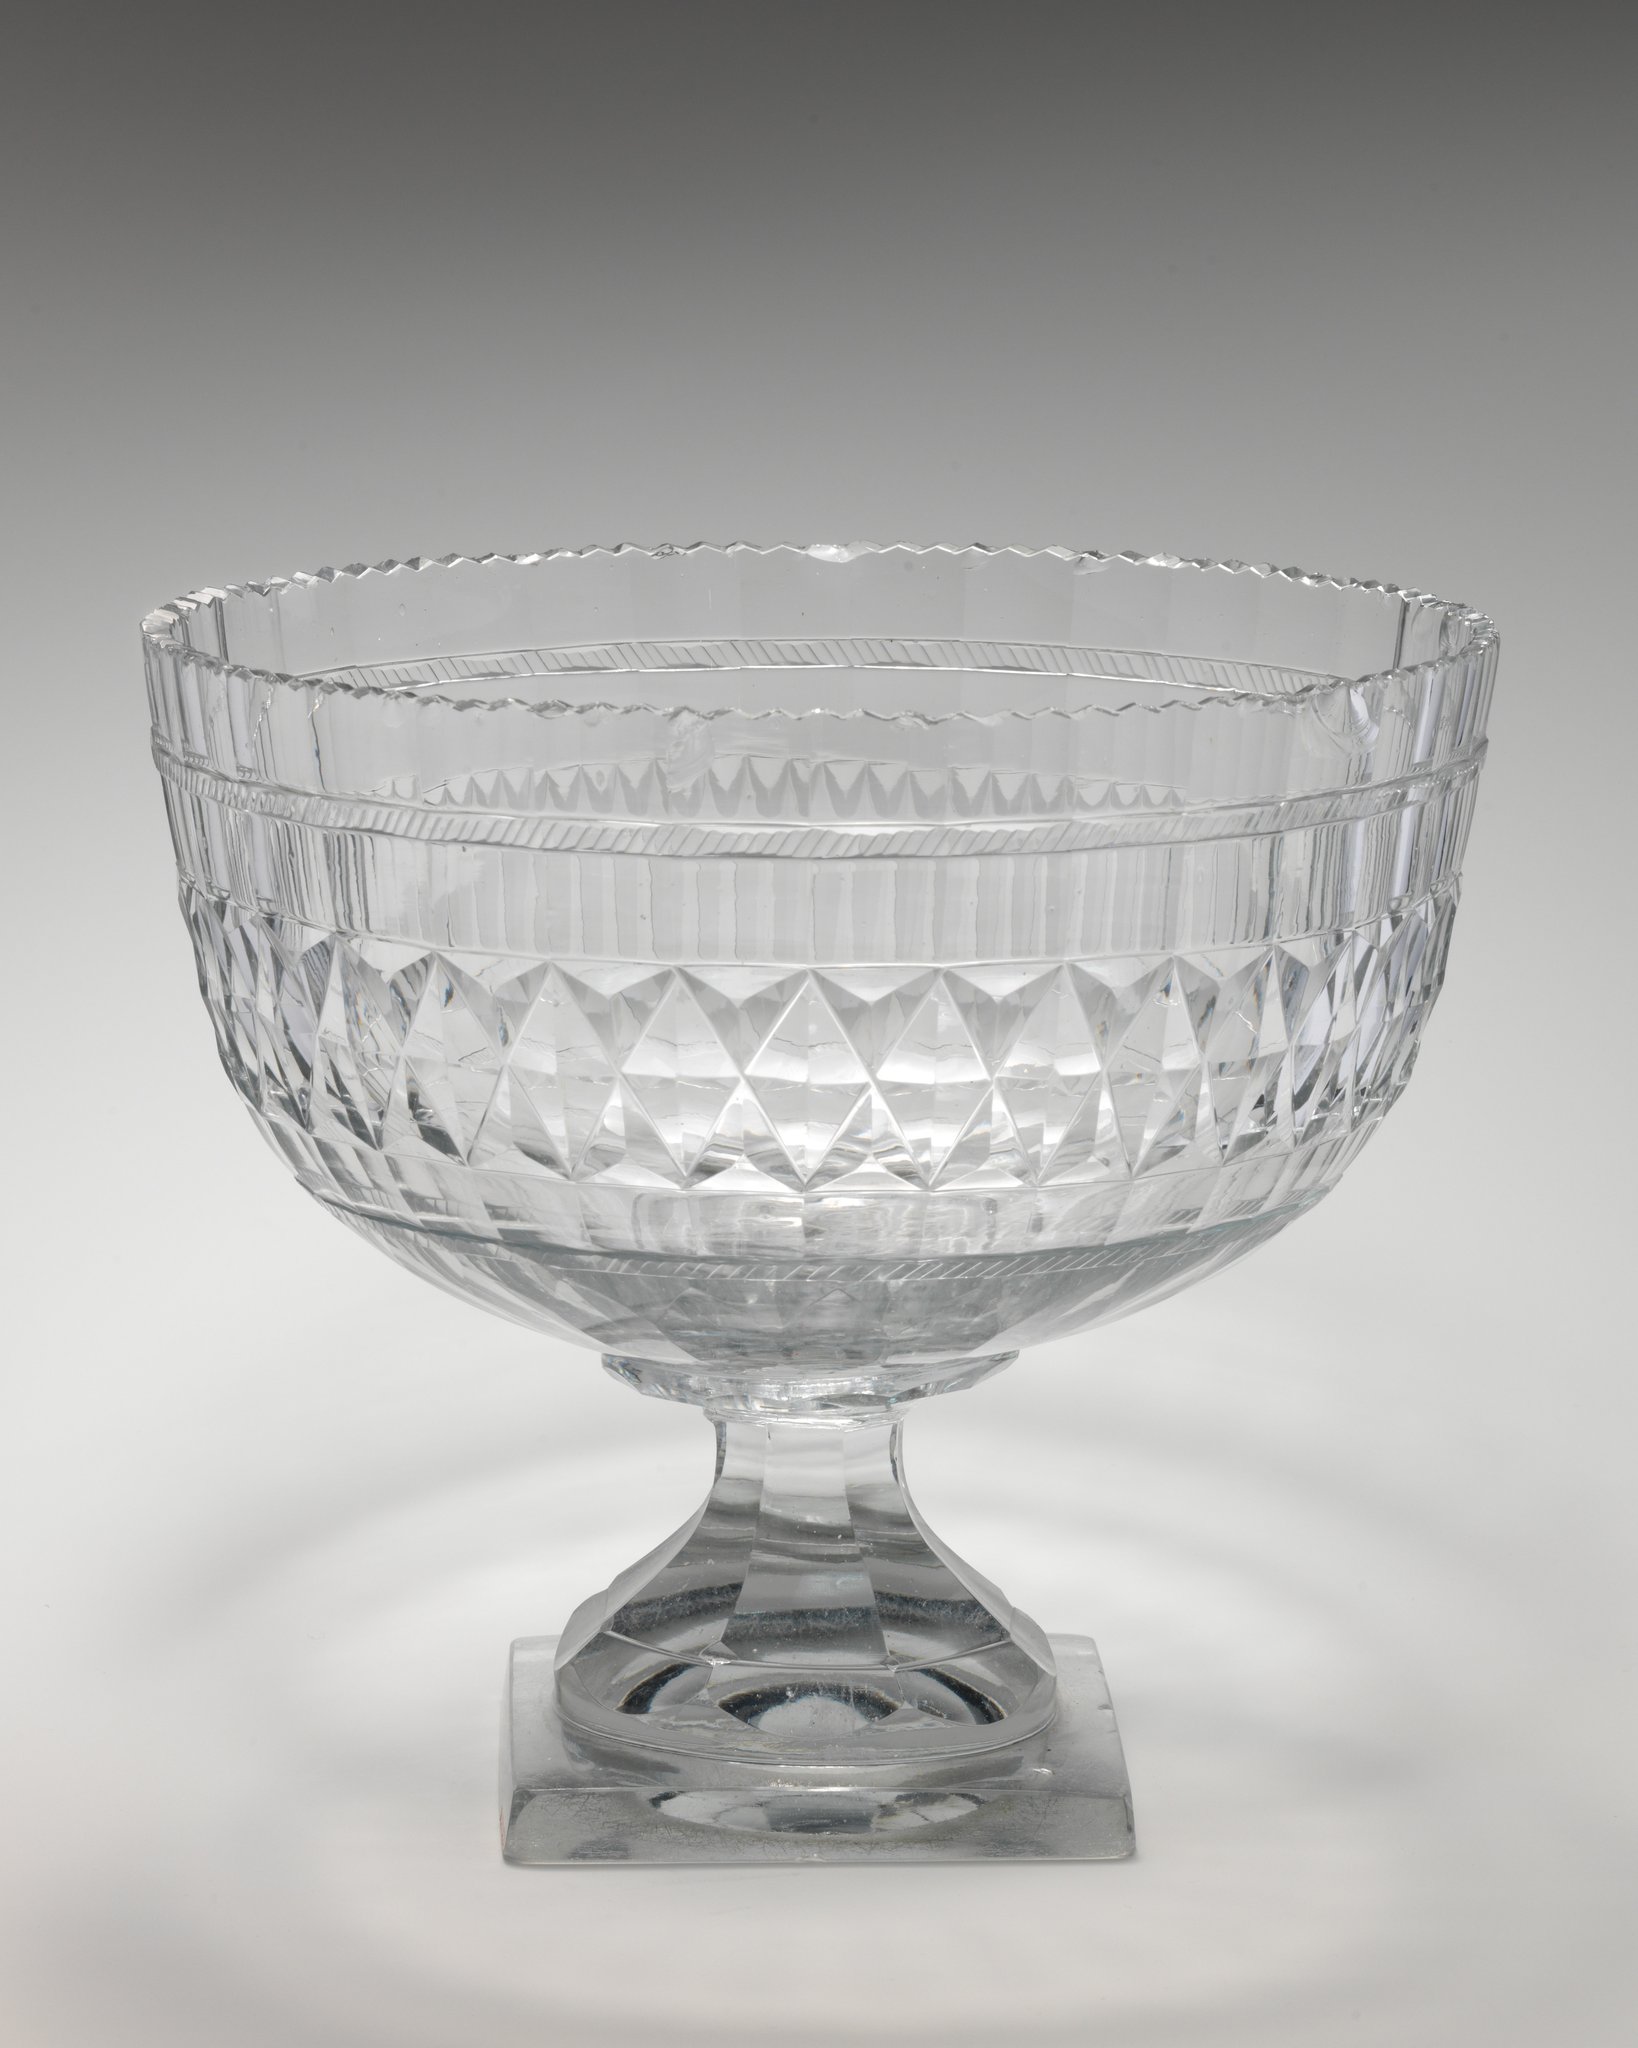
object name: bowl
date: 1801-1900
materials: glass